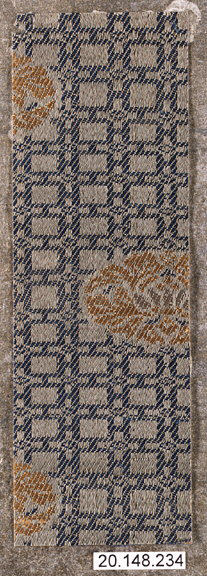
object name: piece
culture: japanese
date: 1701-1800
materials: silk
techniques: compound weave